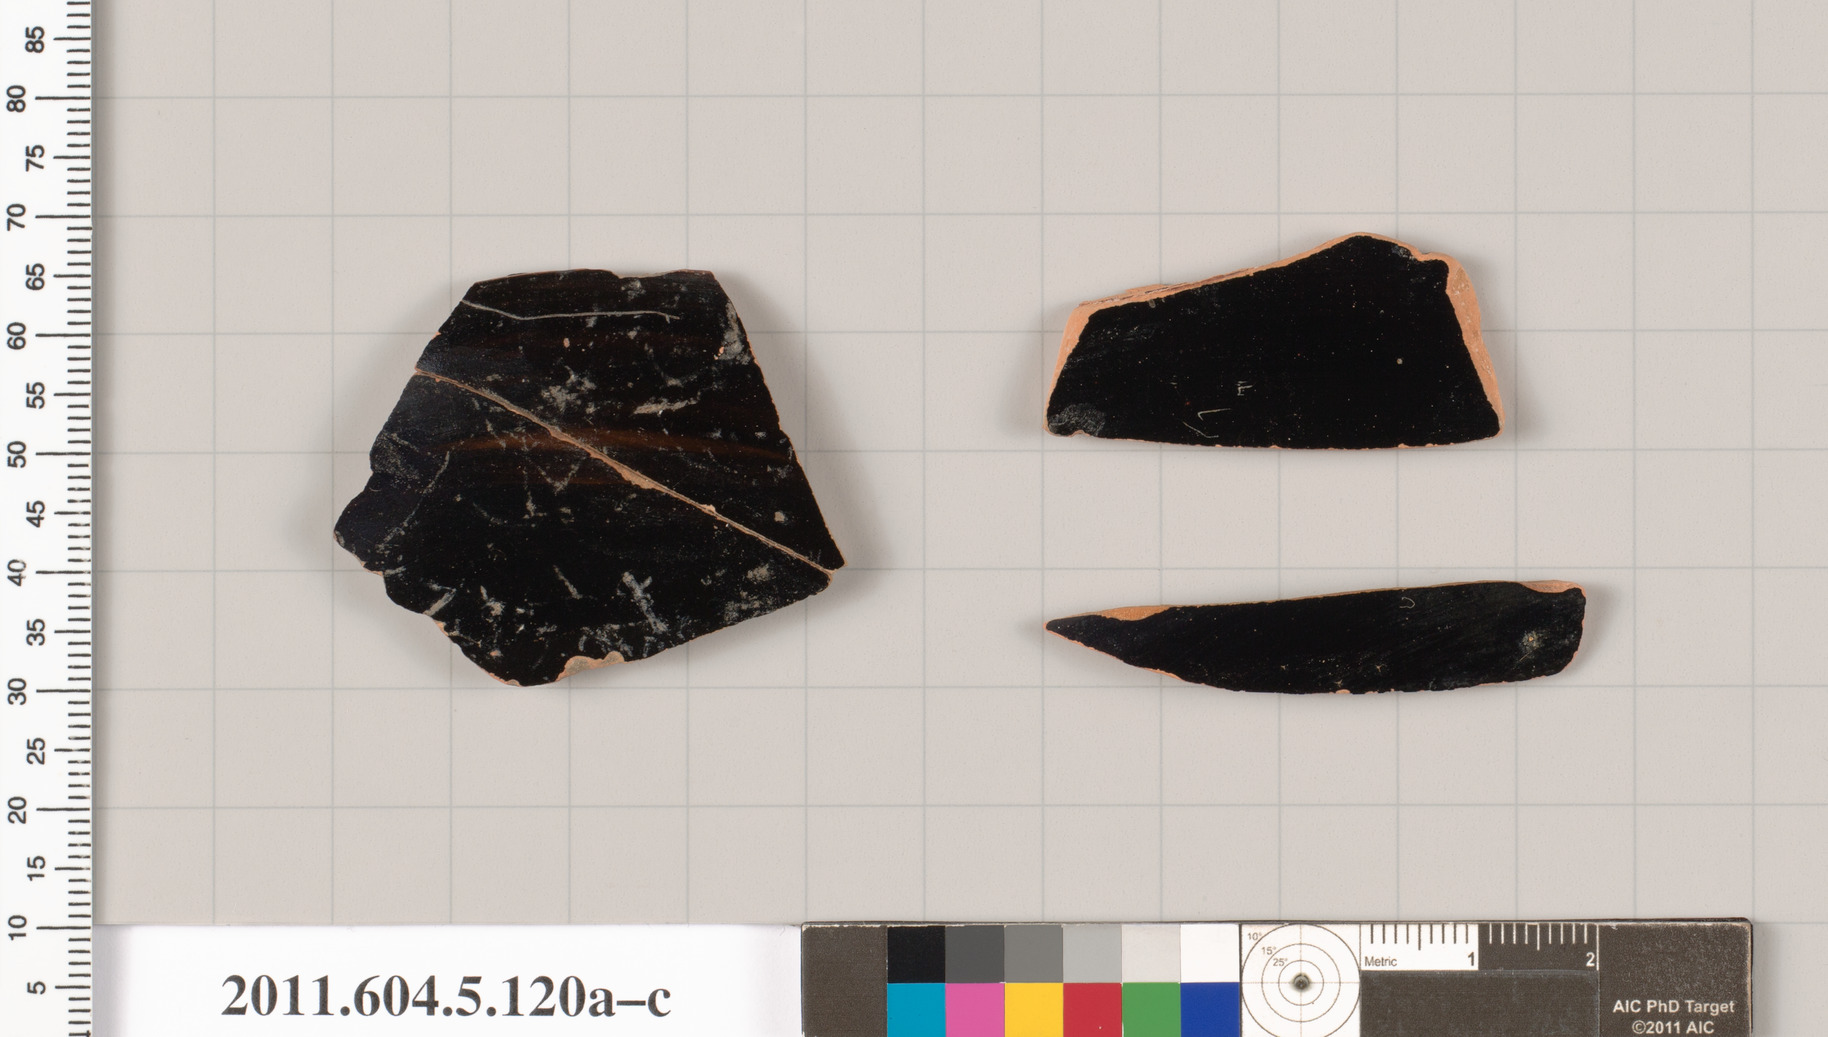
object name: kylix fragment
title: Terracotta fragments of stemless kylikes (drinking cups)?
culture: greek, attic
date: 470-450 BCE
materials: terracotta